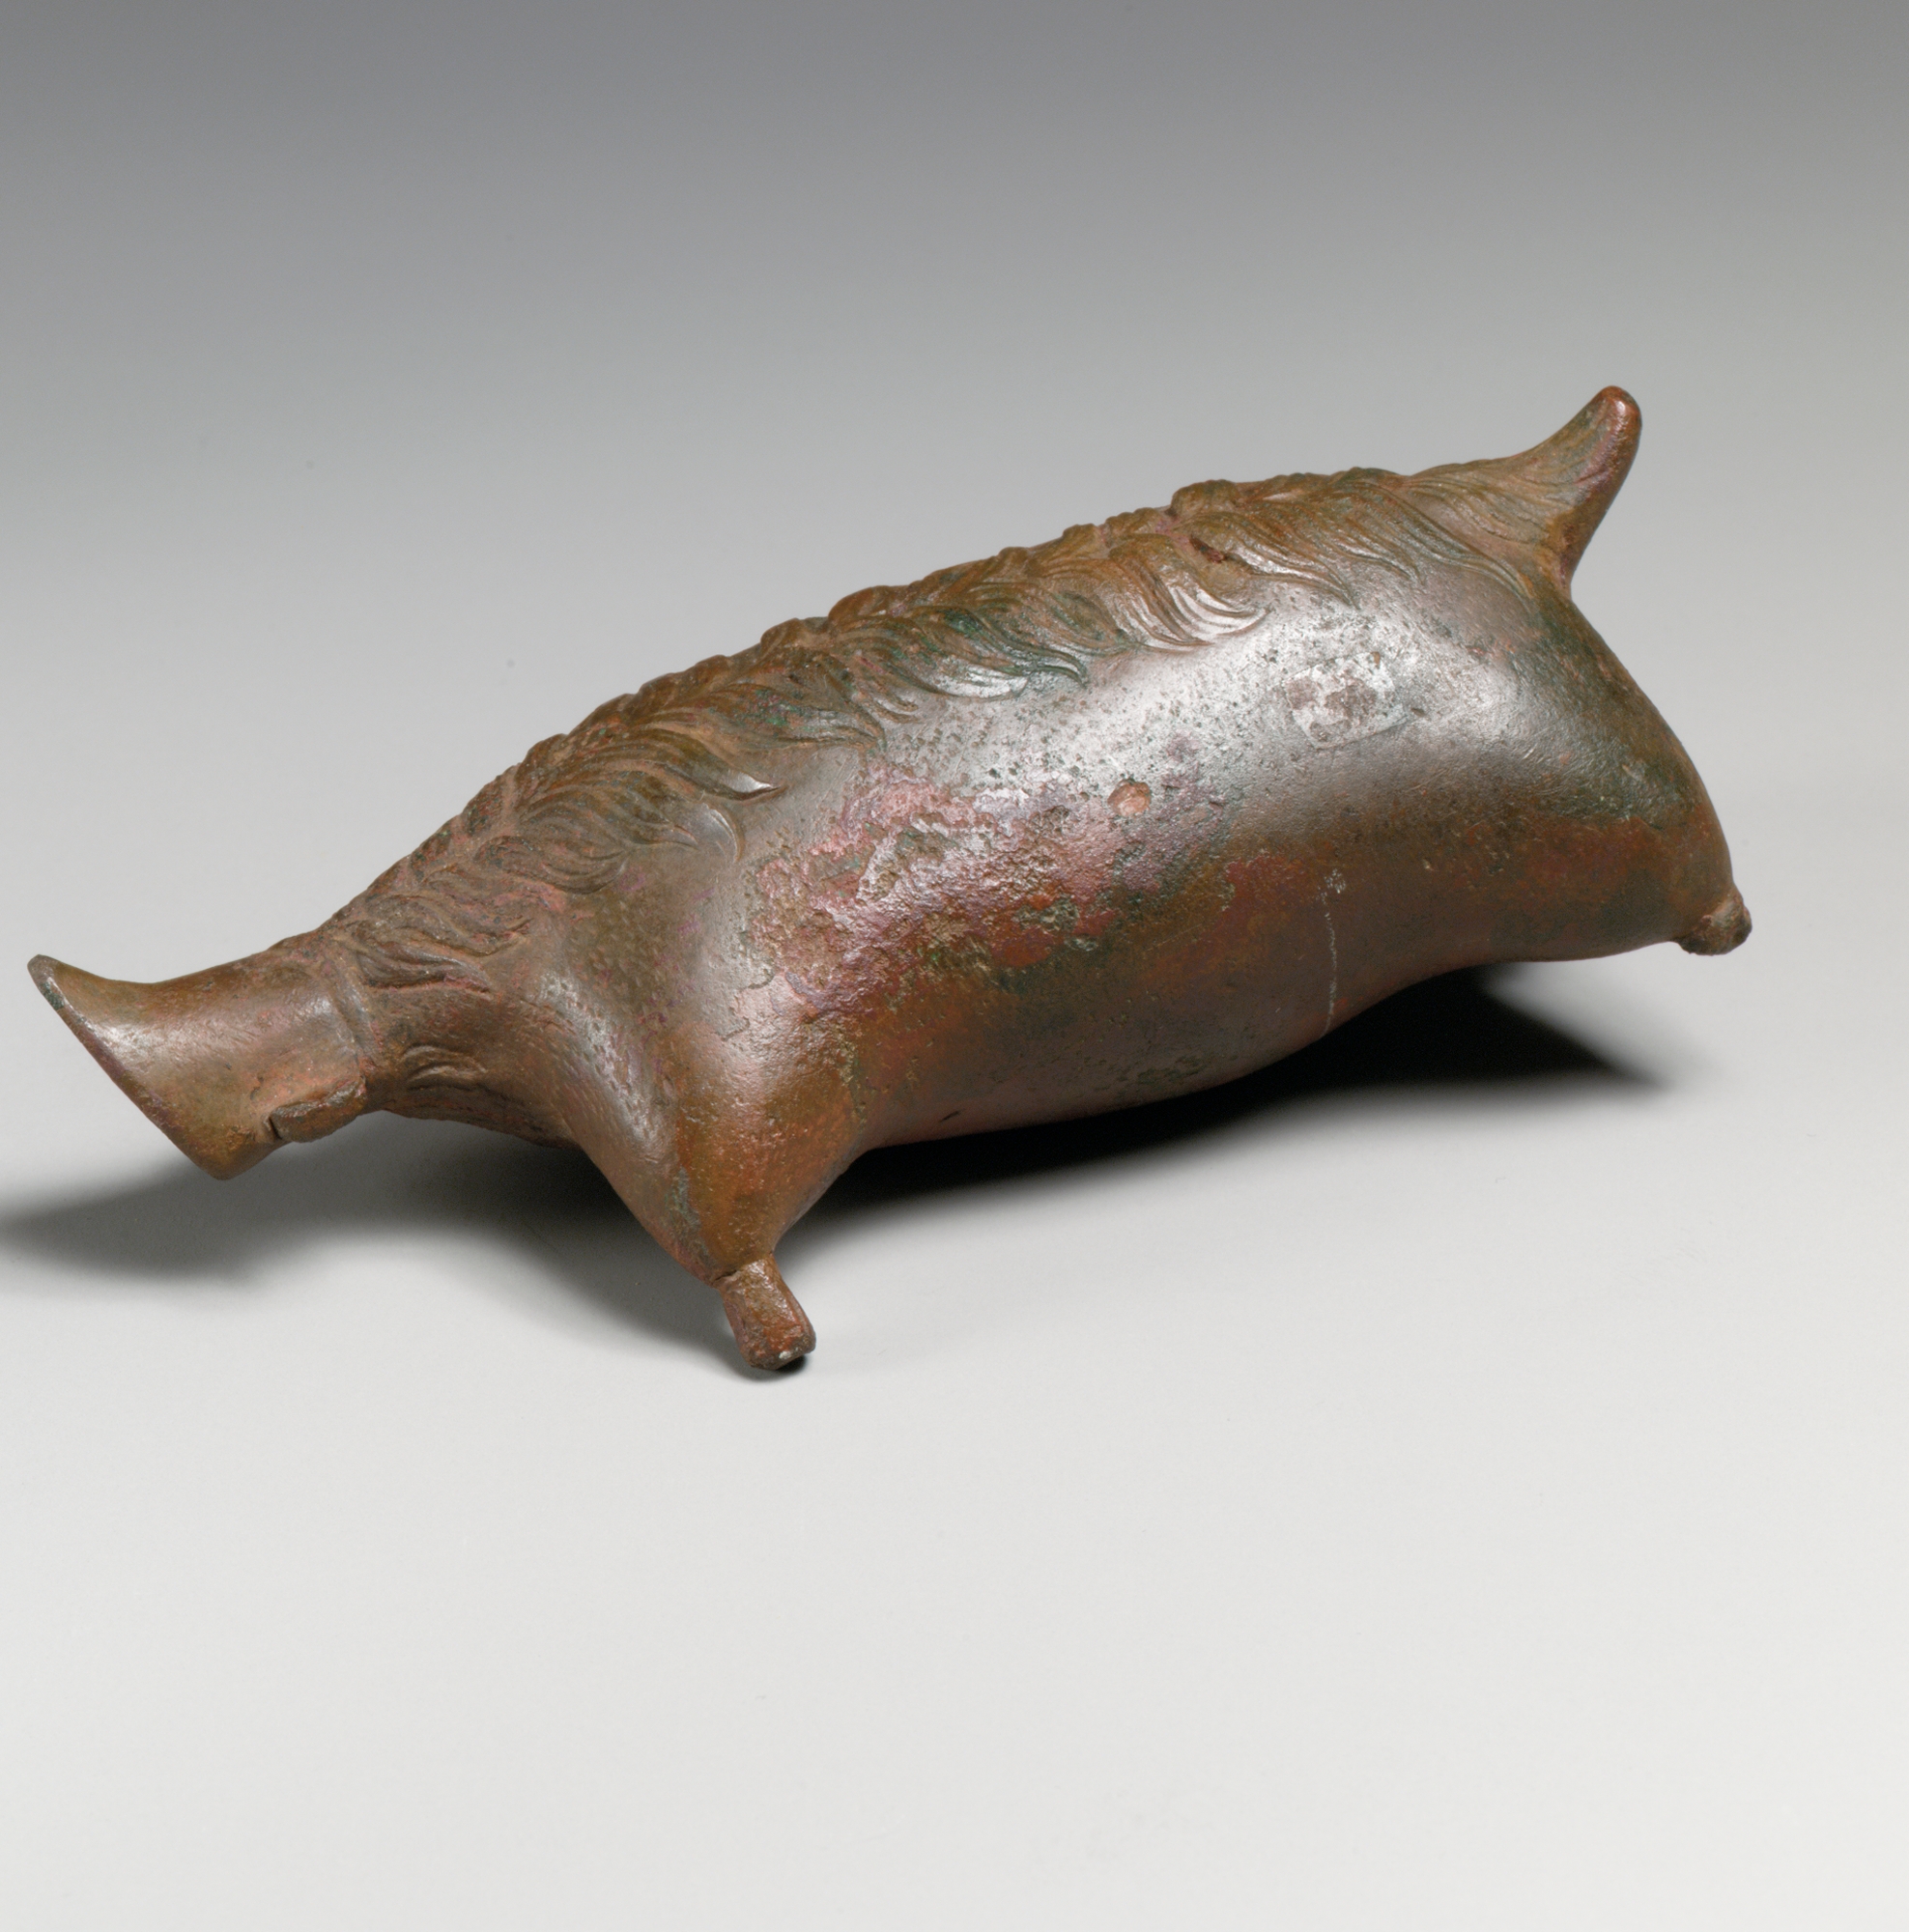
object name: flask askos, goatskin form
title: Bronze askos (flask) in the form of a goatskin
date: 300-1 BCE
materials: bronze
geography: egypt